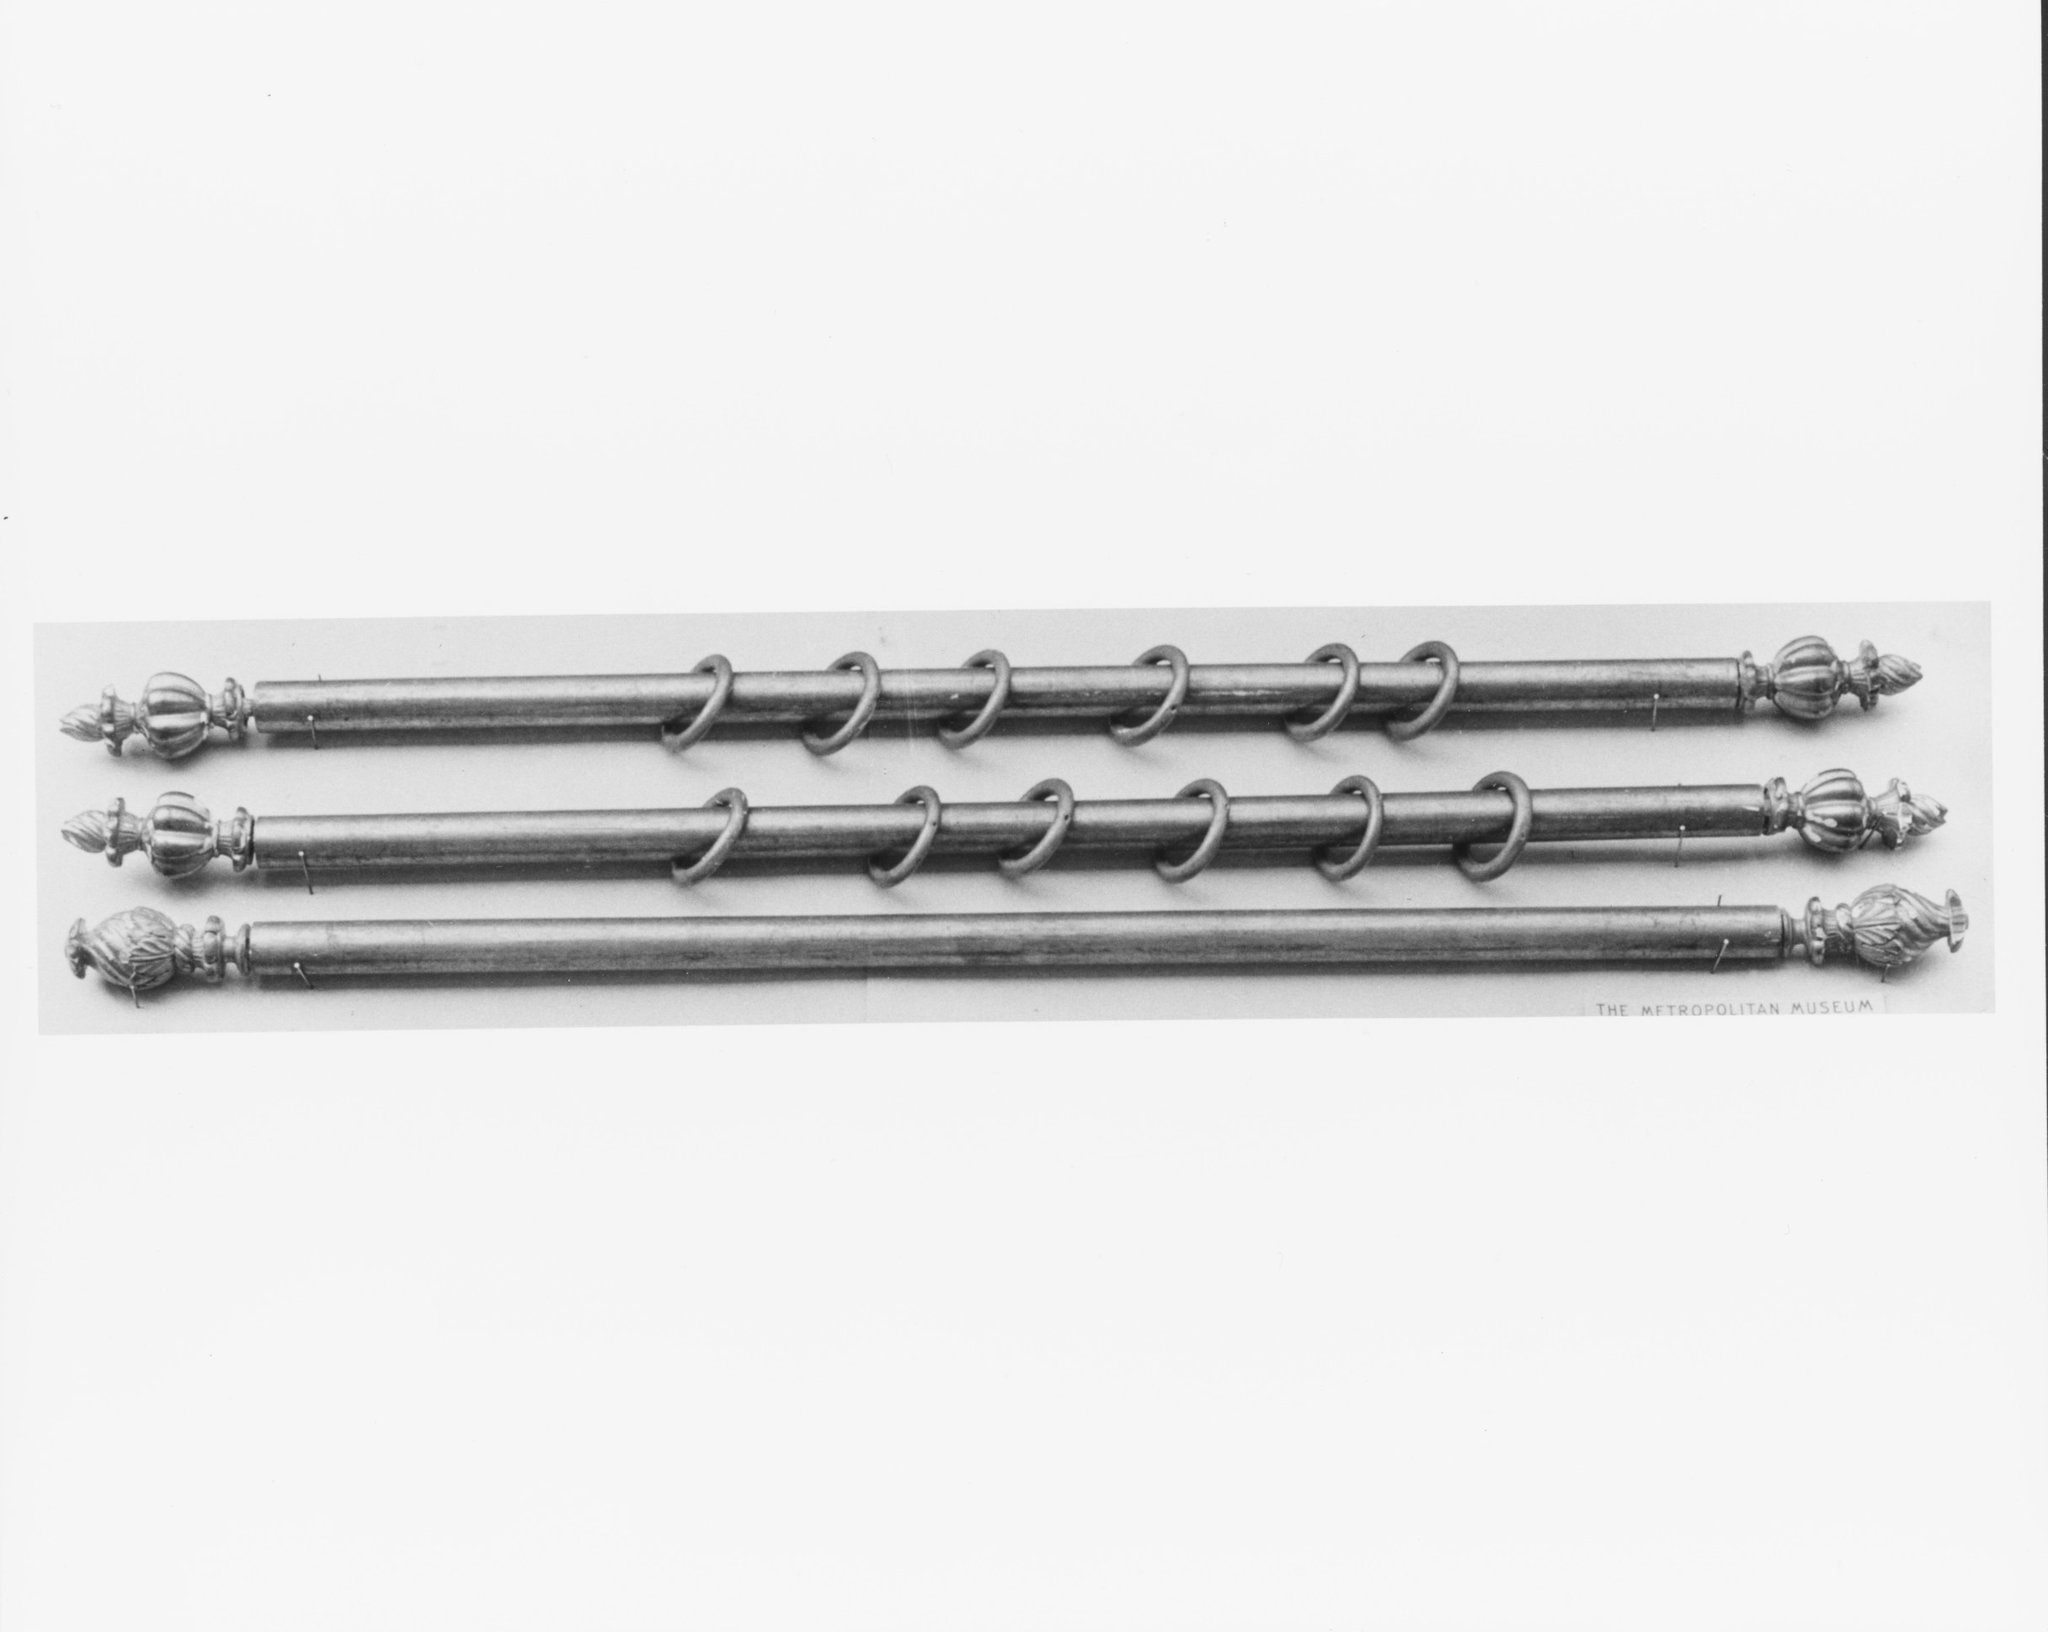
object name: curtain pole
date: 1770-1800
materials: plaster, wood